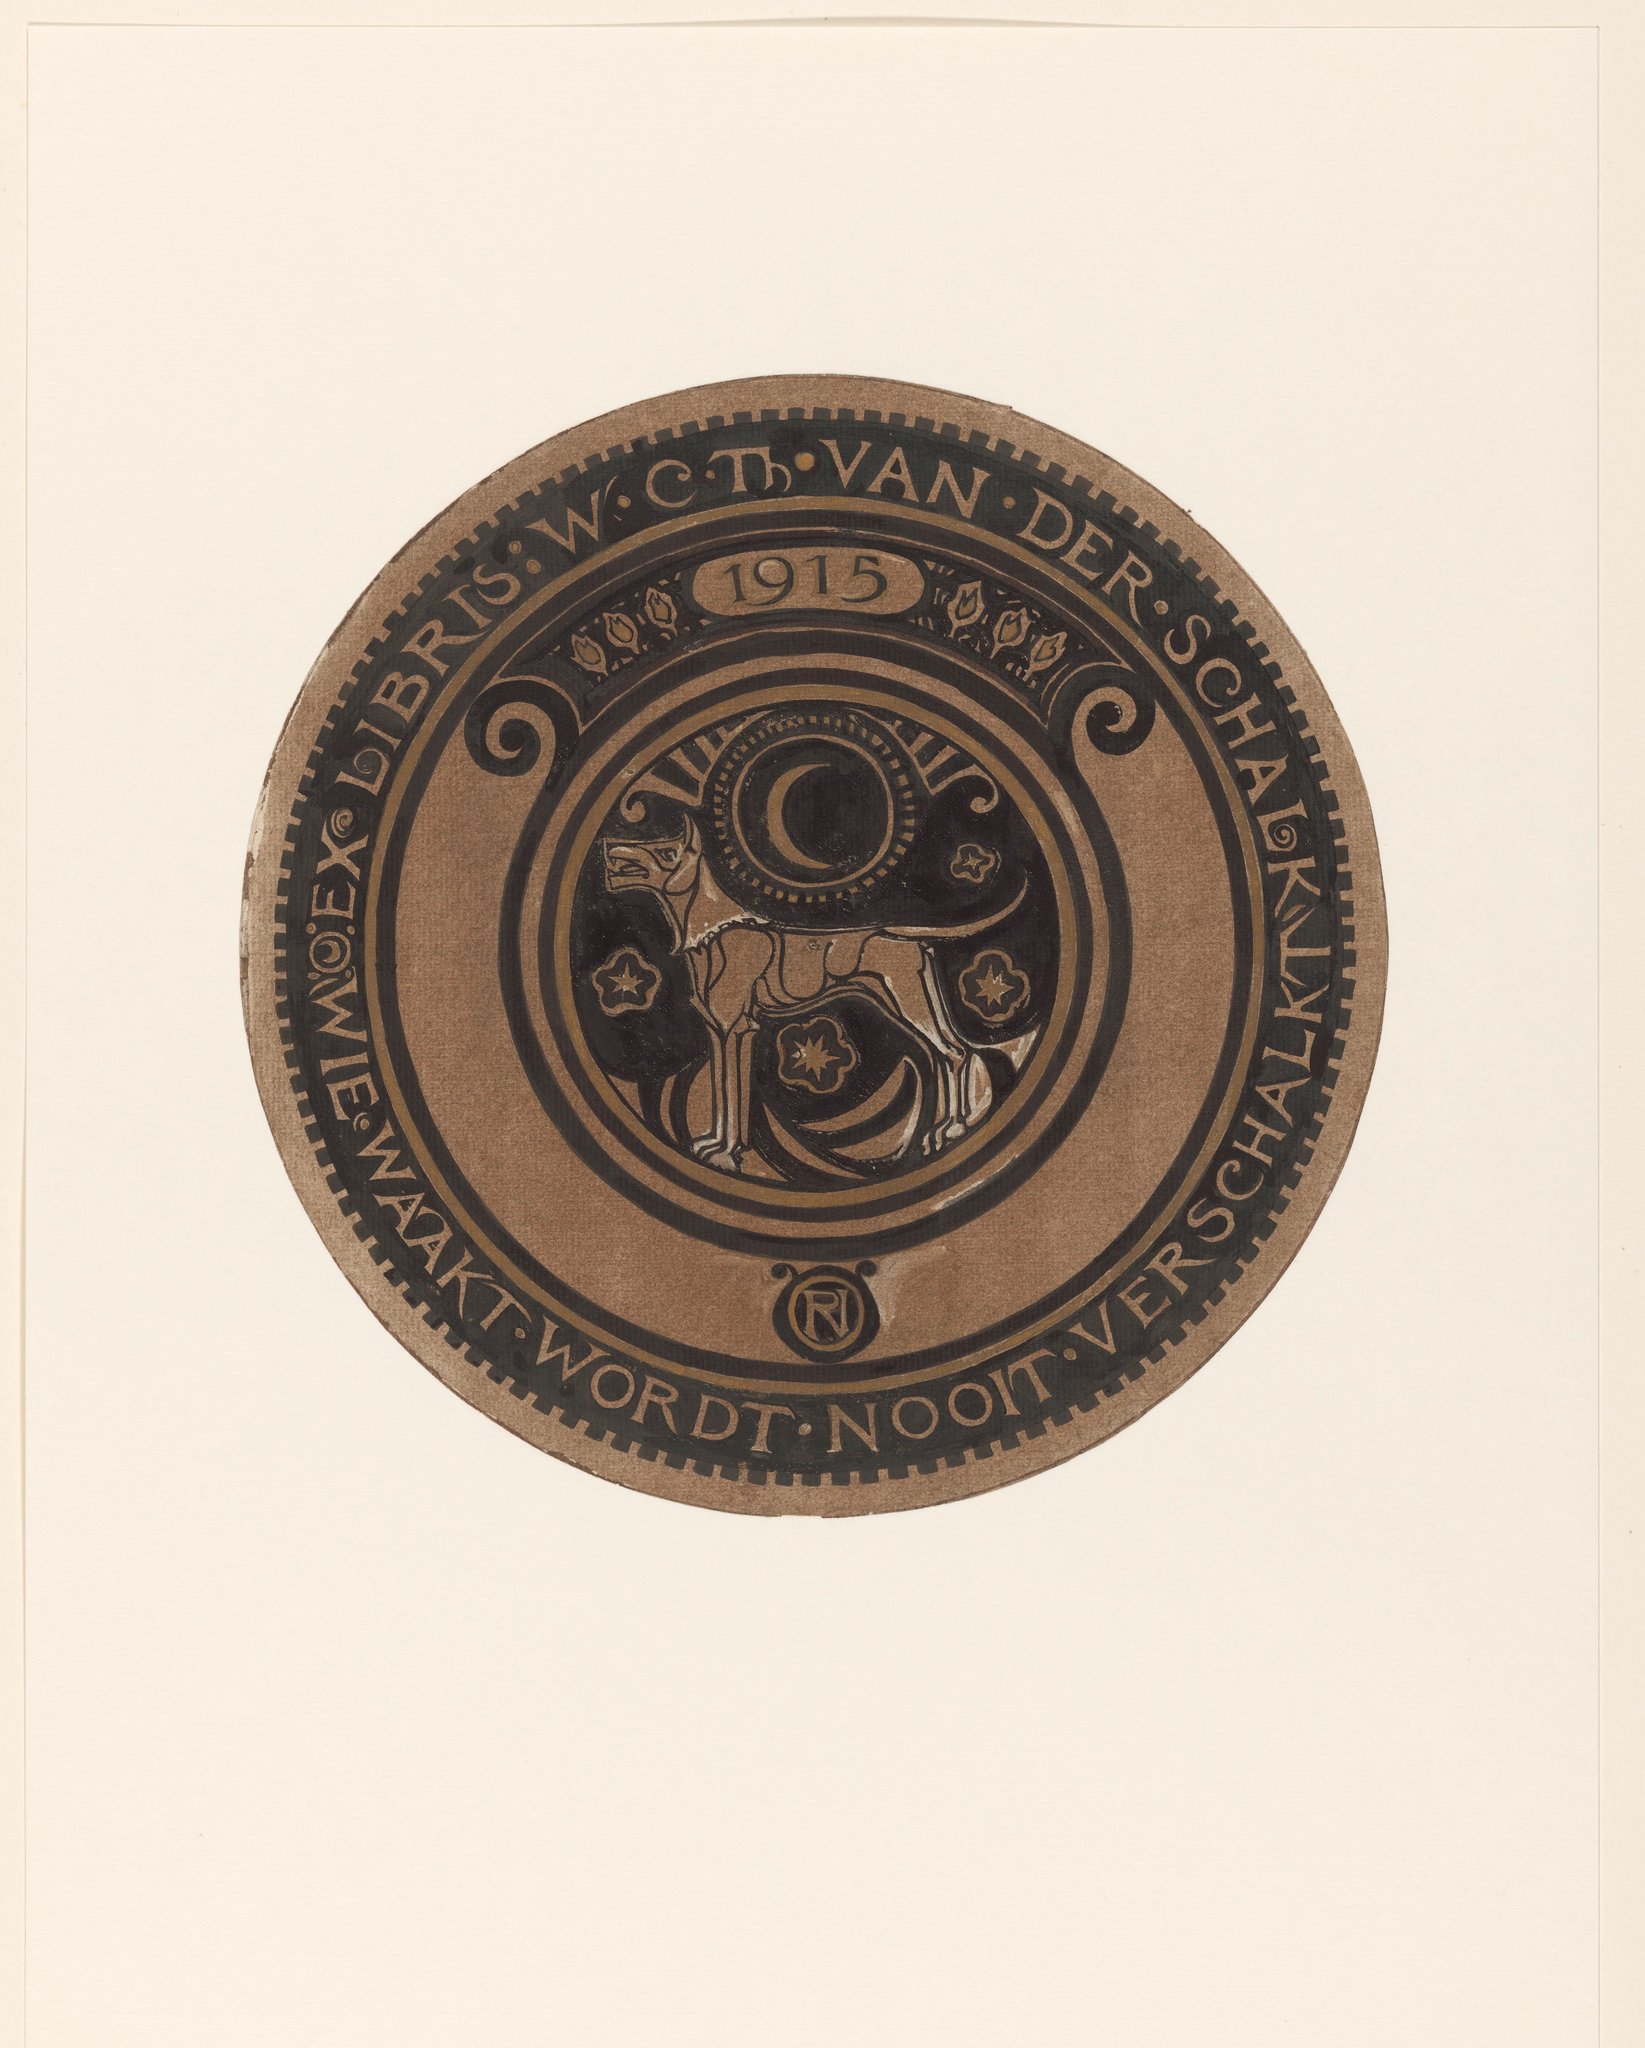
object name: drawing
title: Ontwerp voor ex libris van W.C.Th. van der Schalk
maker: richard nicolaüs roland holst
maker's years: 1868-1938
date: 1915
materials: paint, paper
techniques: brush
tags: historical persons, ex-libris, dog